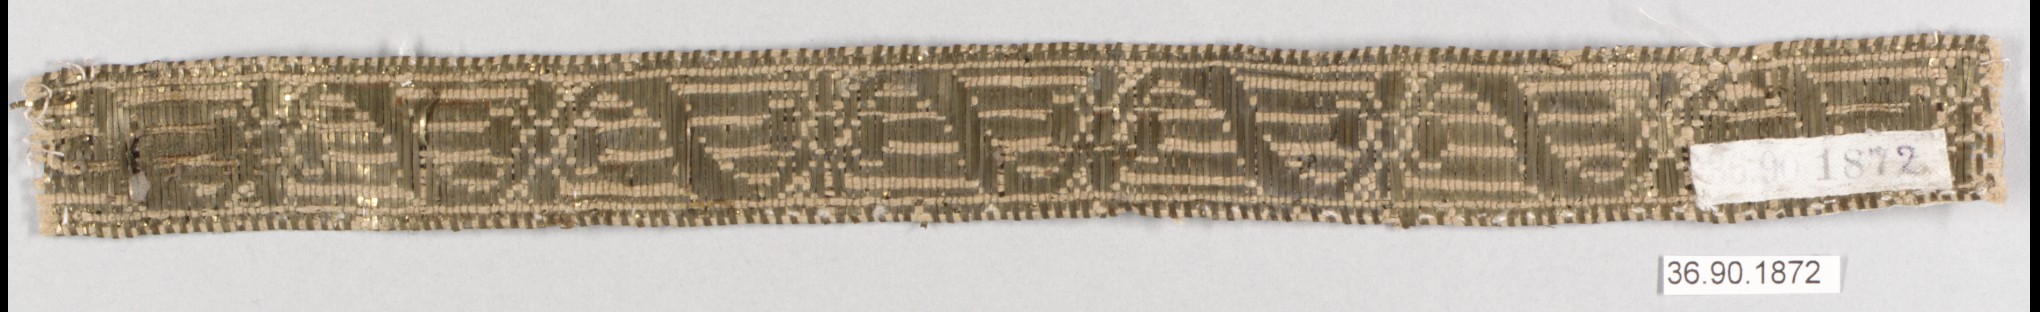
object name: galloon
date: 1801-1900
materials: linen, metal thread